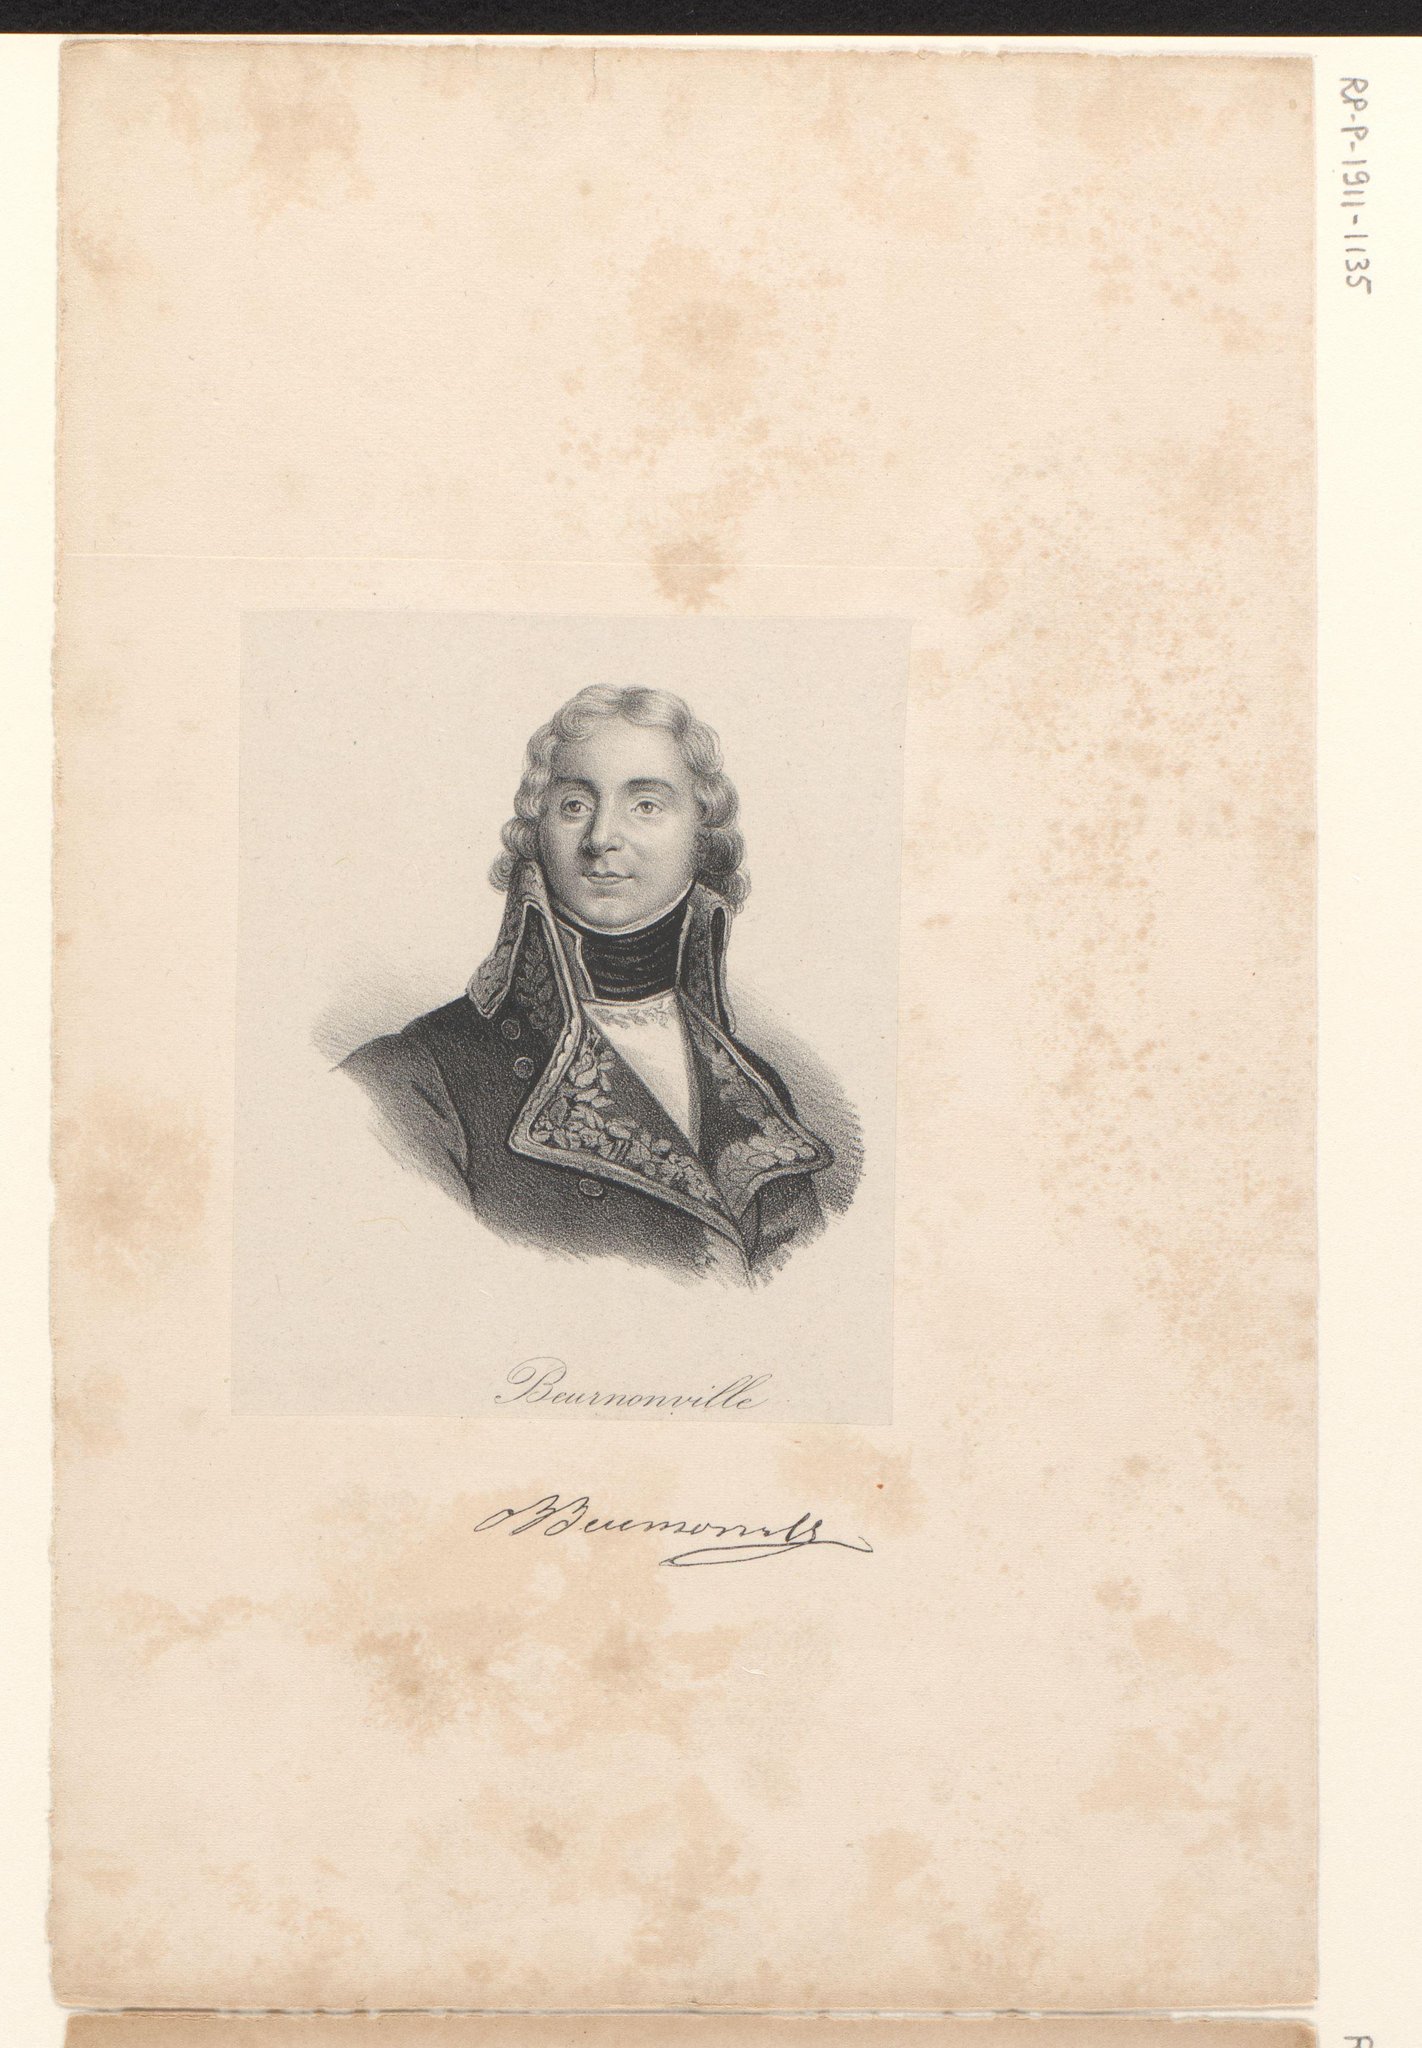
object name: print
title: Portret van Pierre Riel de Beurnonville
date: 1818-1842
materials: paper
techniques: lithograph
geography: paris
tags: historical persons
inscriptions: collector's mark: Lugt 2228a